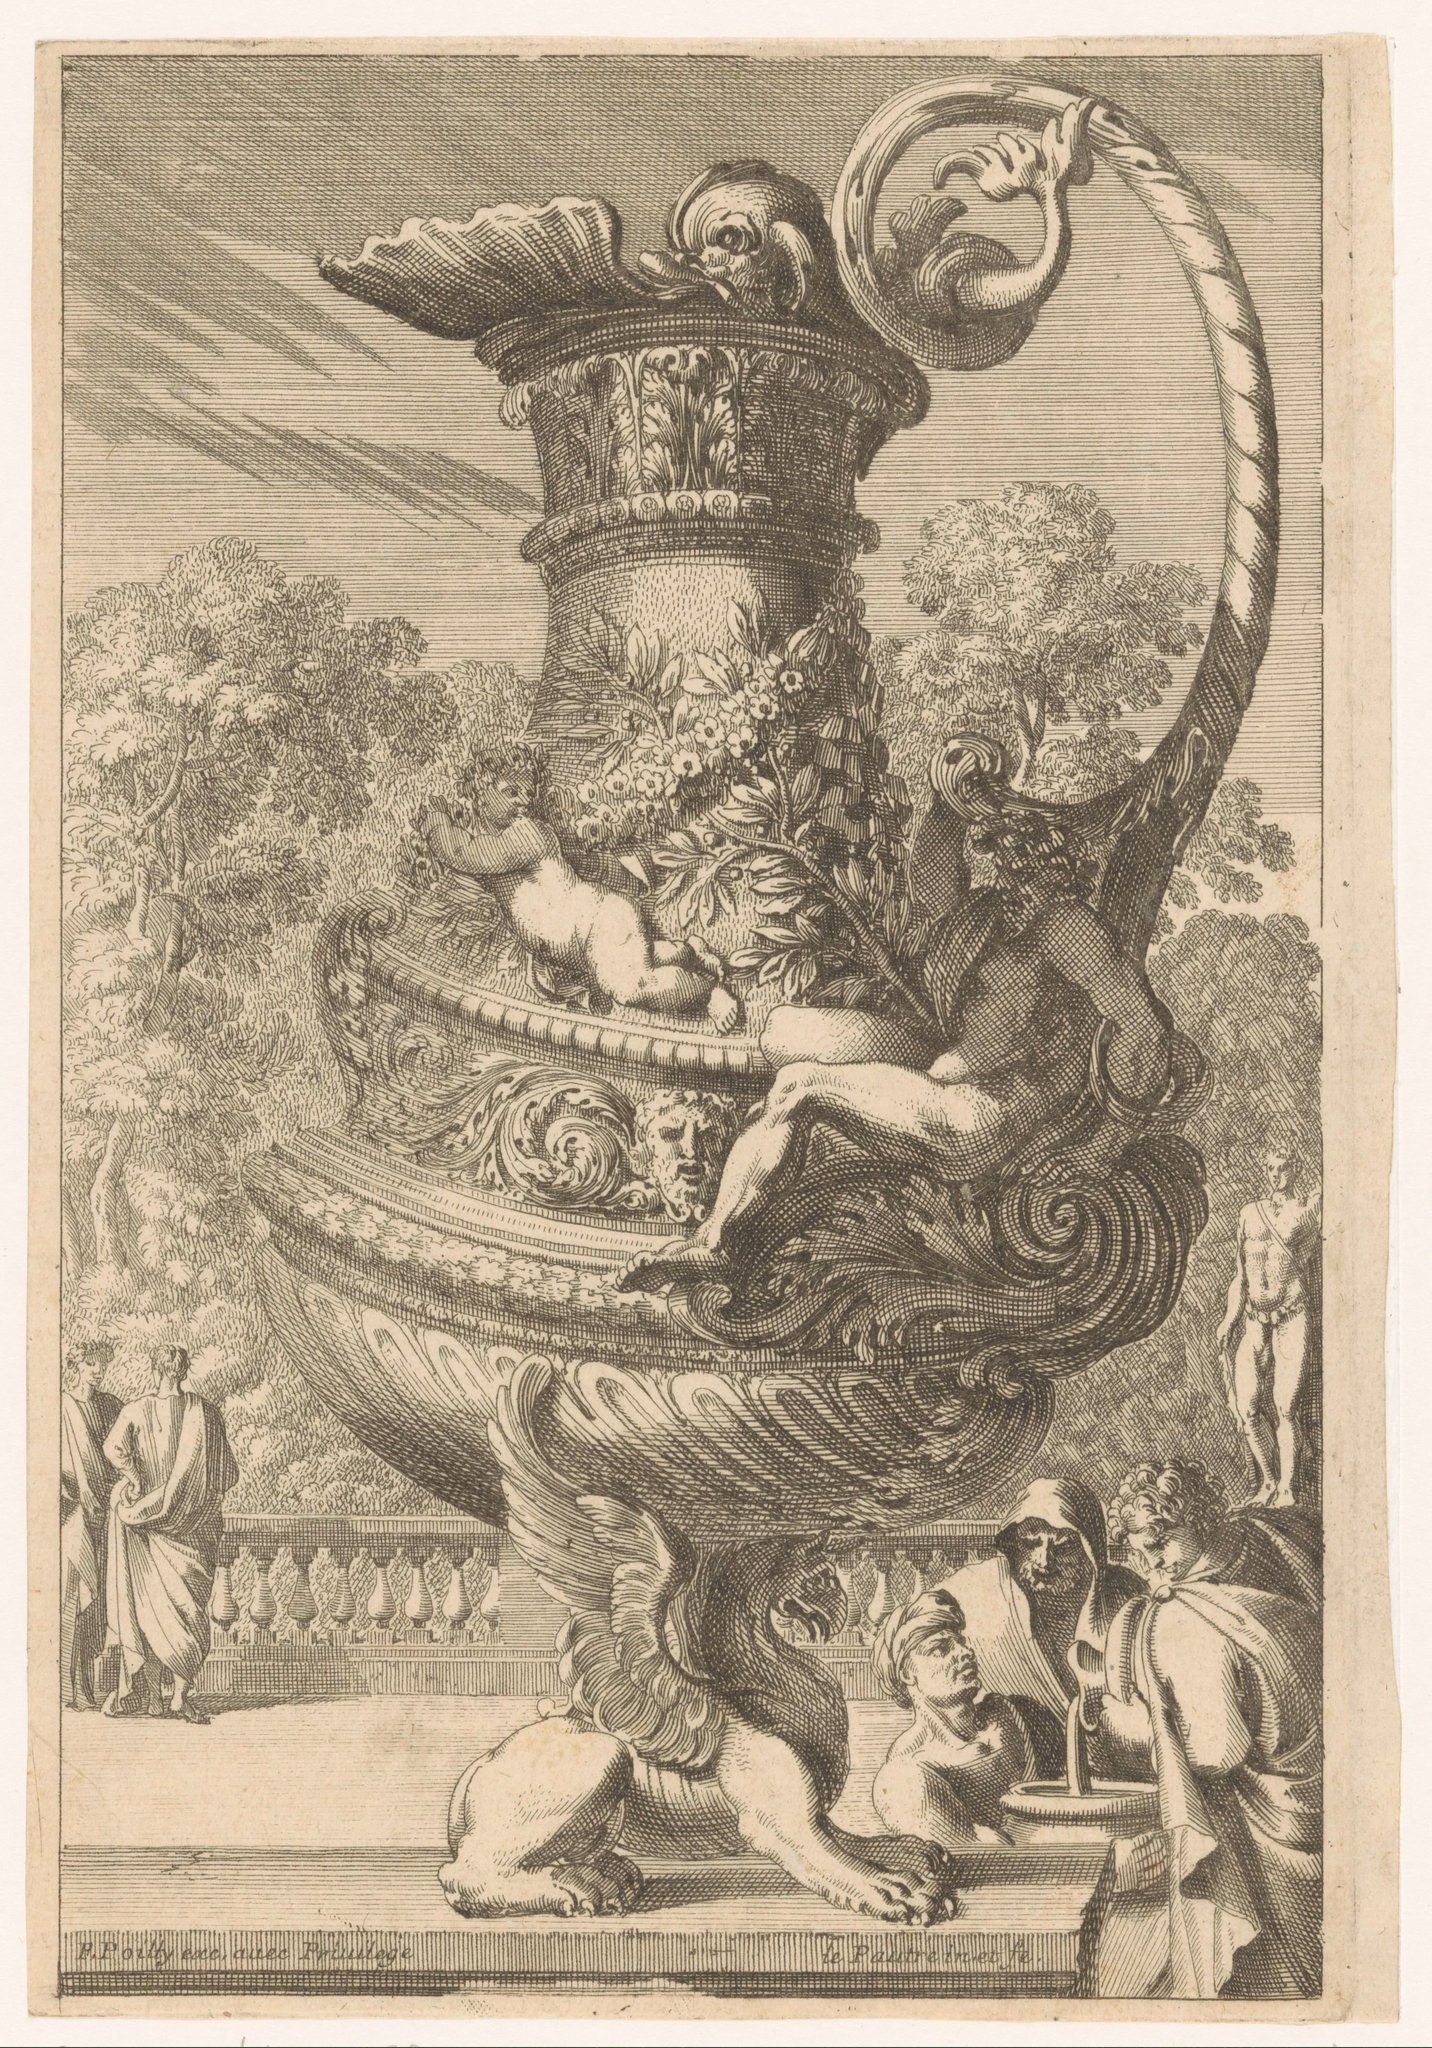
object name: print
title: Vazen en schenkkannen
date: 1669-1693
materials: paper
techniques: etching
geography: paris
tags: jar, jug (used as drinking-vessel)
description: Kan met handvat in de vorm van een dolfijn, een griffioen als voet en op het lichaam een putto en een zittende man.